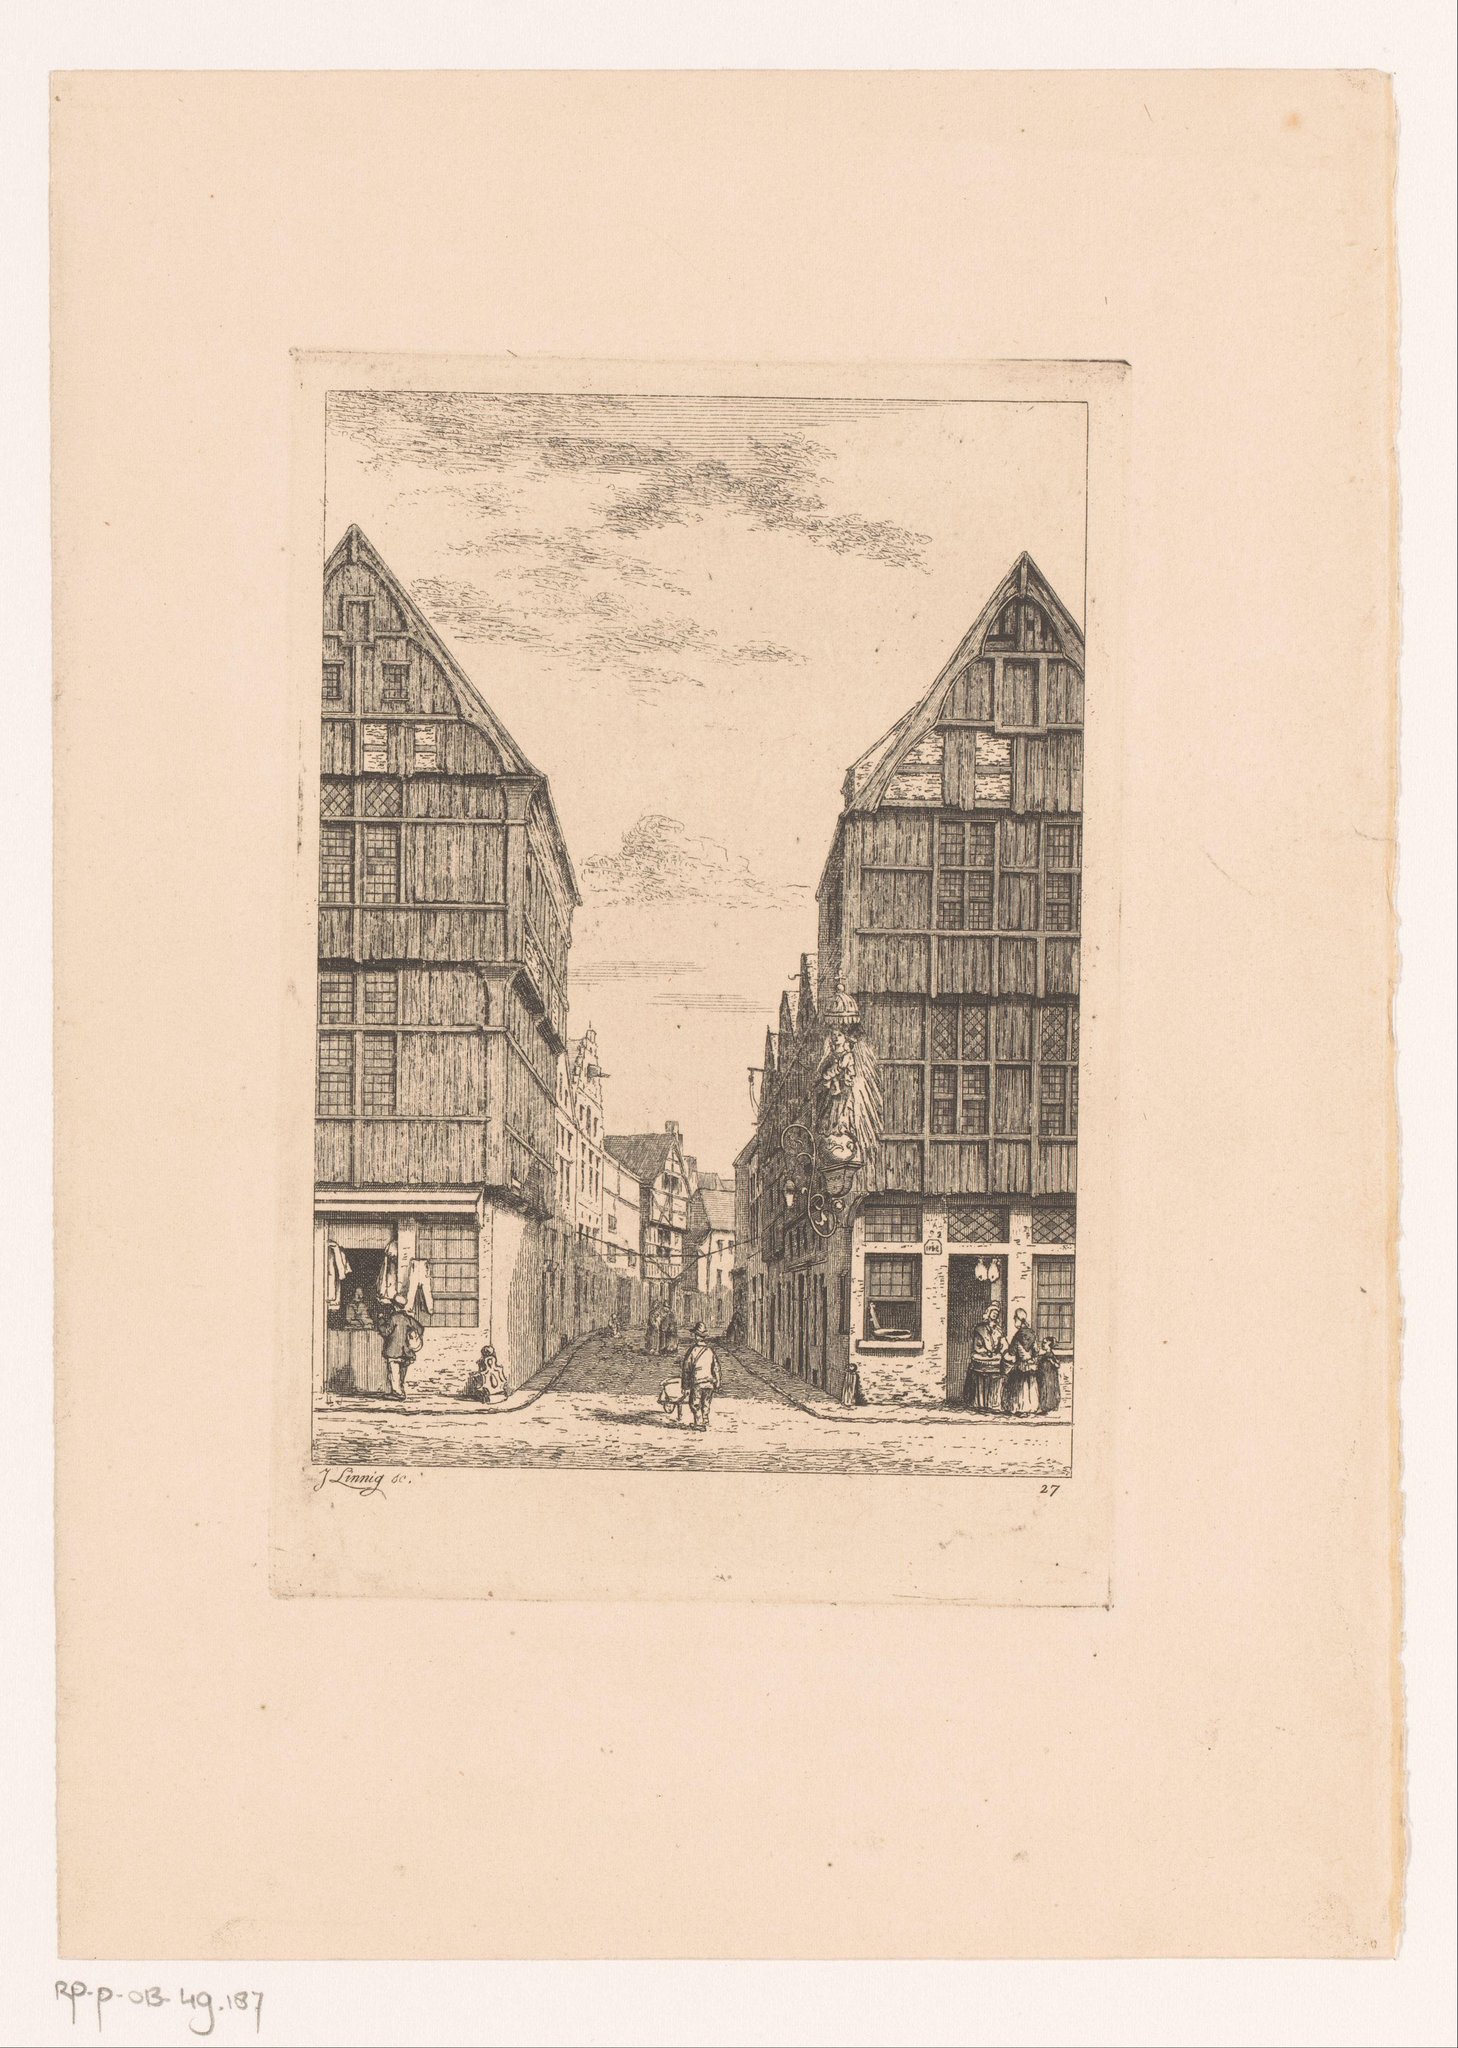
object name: print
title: Gezicht op de Stoelstraat in Antwerpen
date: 1868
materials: paper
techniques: etching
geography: antwerp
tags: street, antwerp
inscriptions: collector's mark: Lugt 2228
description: Prent uit: Mertens, F.H. Album historique de la ville d'Anvers [...]. Antwerpen: J.E. Buschmann, 1868.